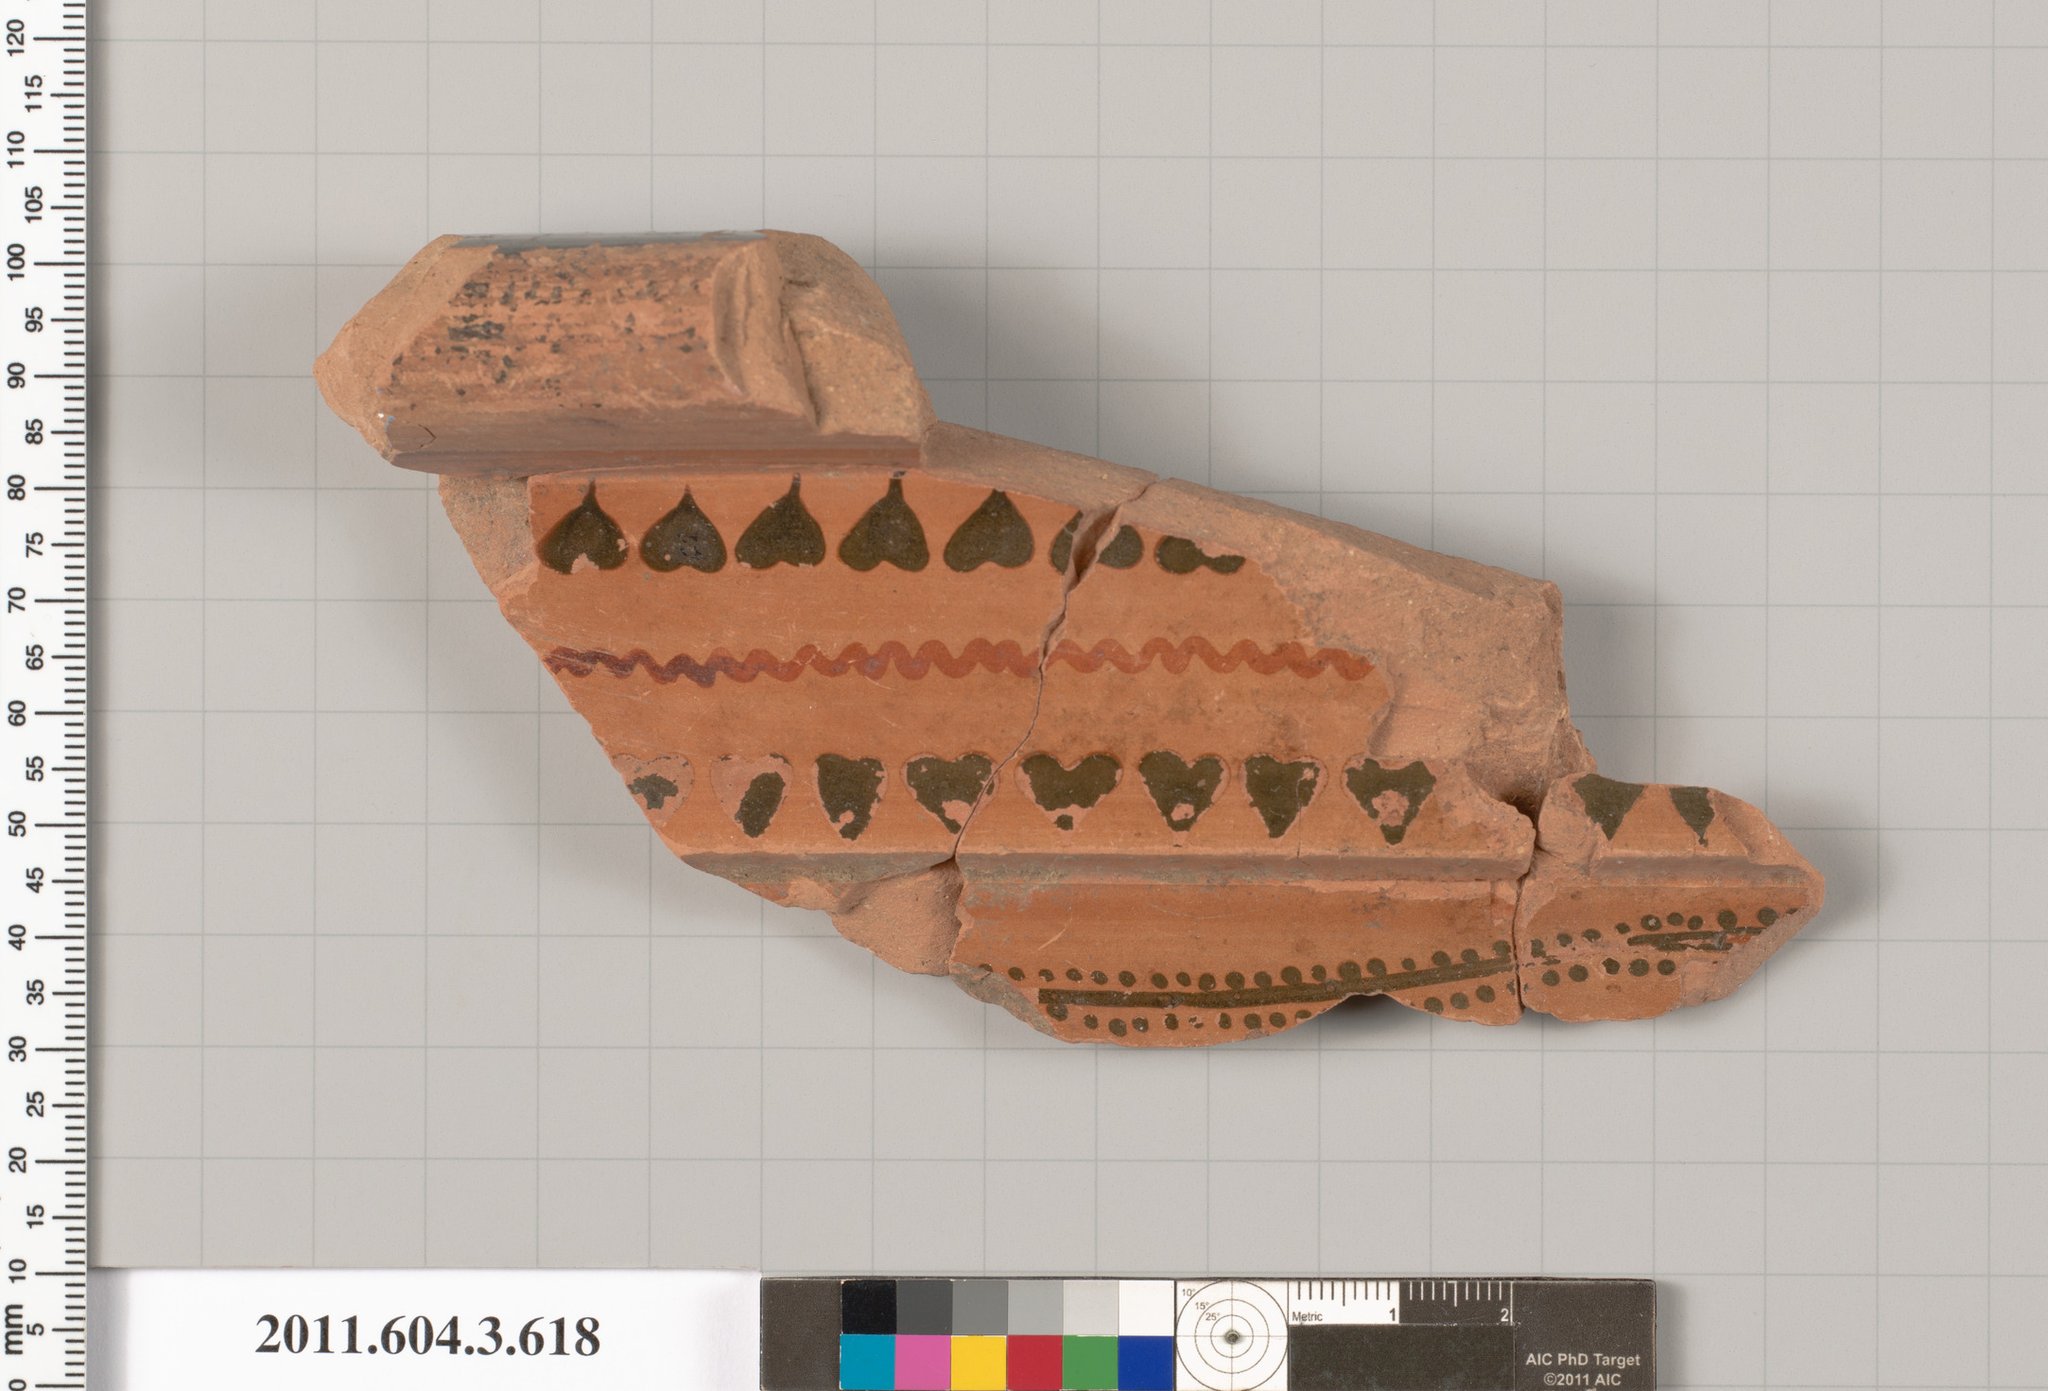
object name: calyx krater fragment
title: Terracotta fragment of a calyx-krater (bowl for mixing wine and water)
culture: greek, attic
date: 525-501 BCE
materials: terracotta